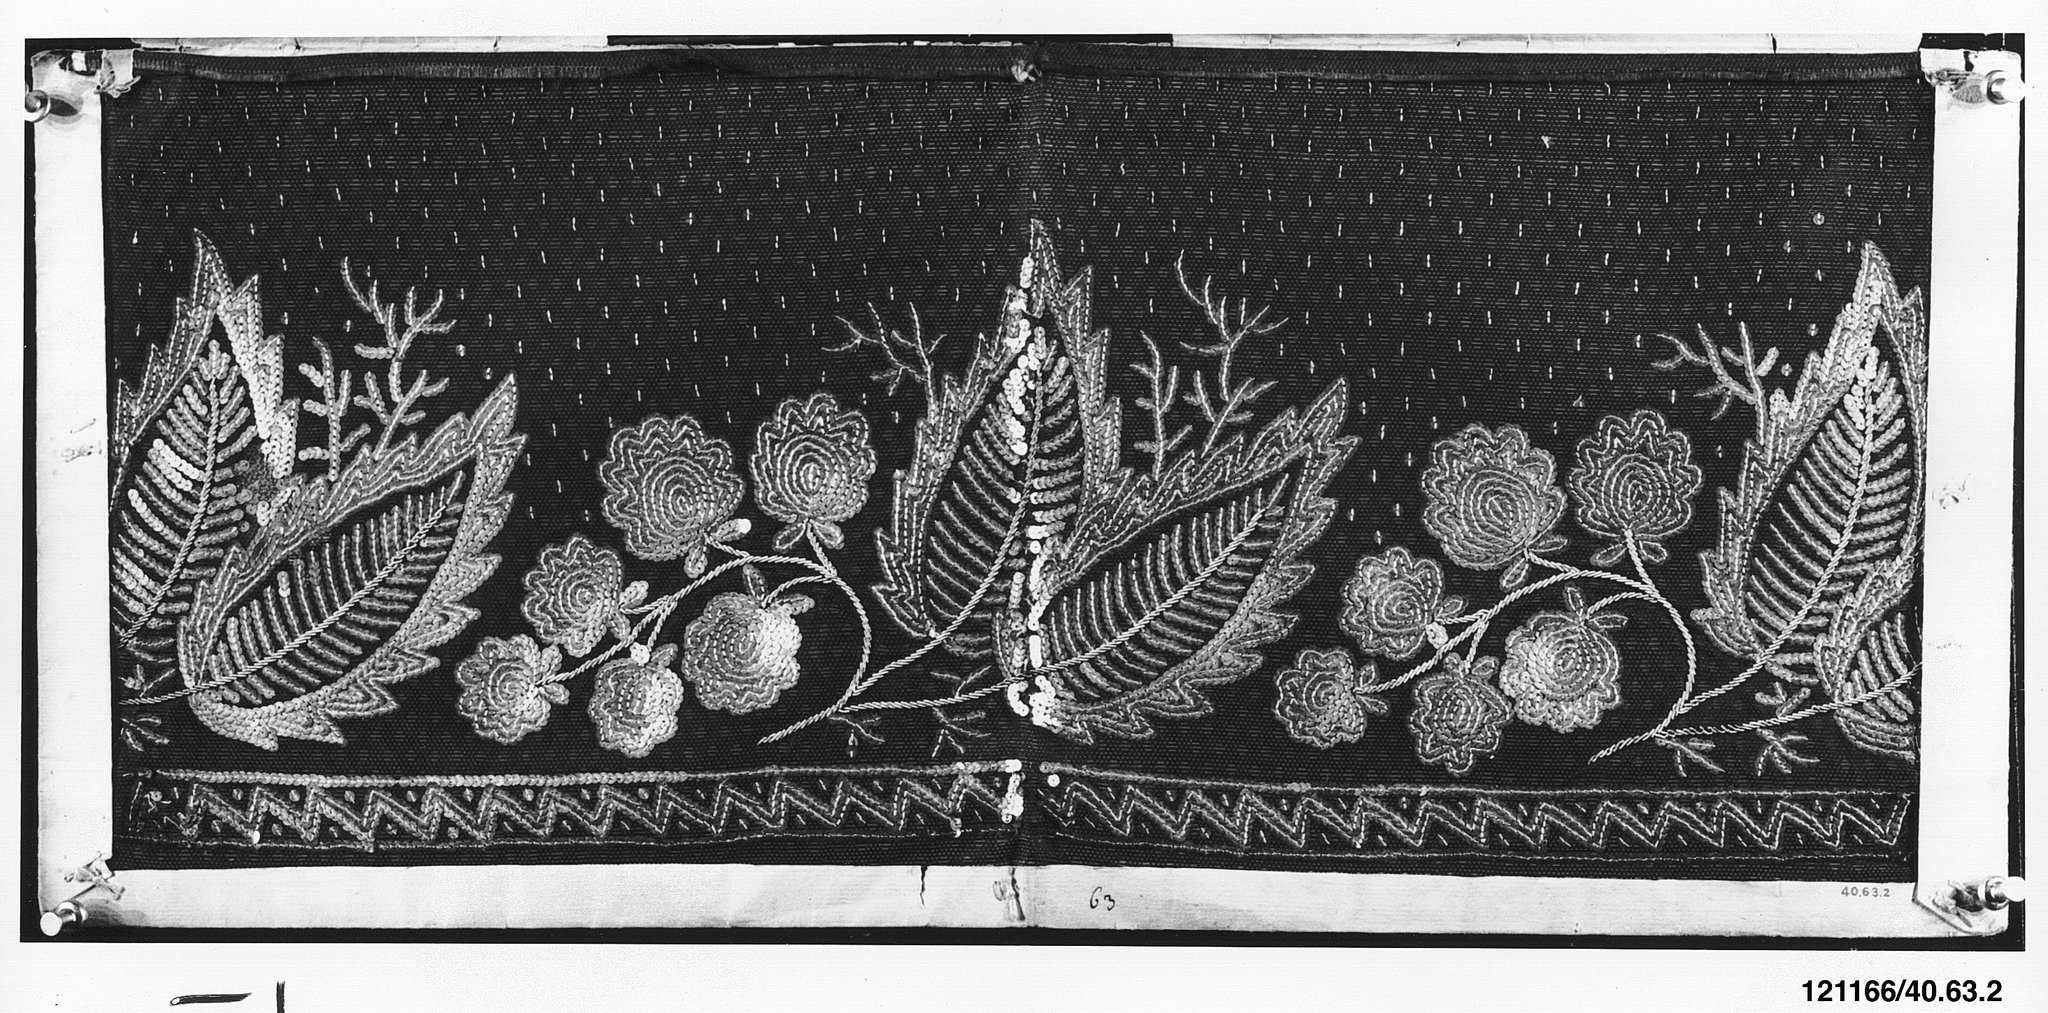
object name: border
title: Dress border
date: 1805-1815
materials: silk, silver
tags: flowers